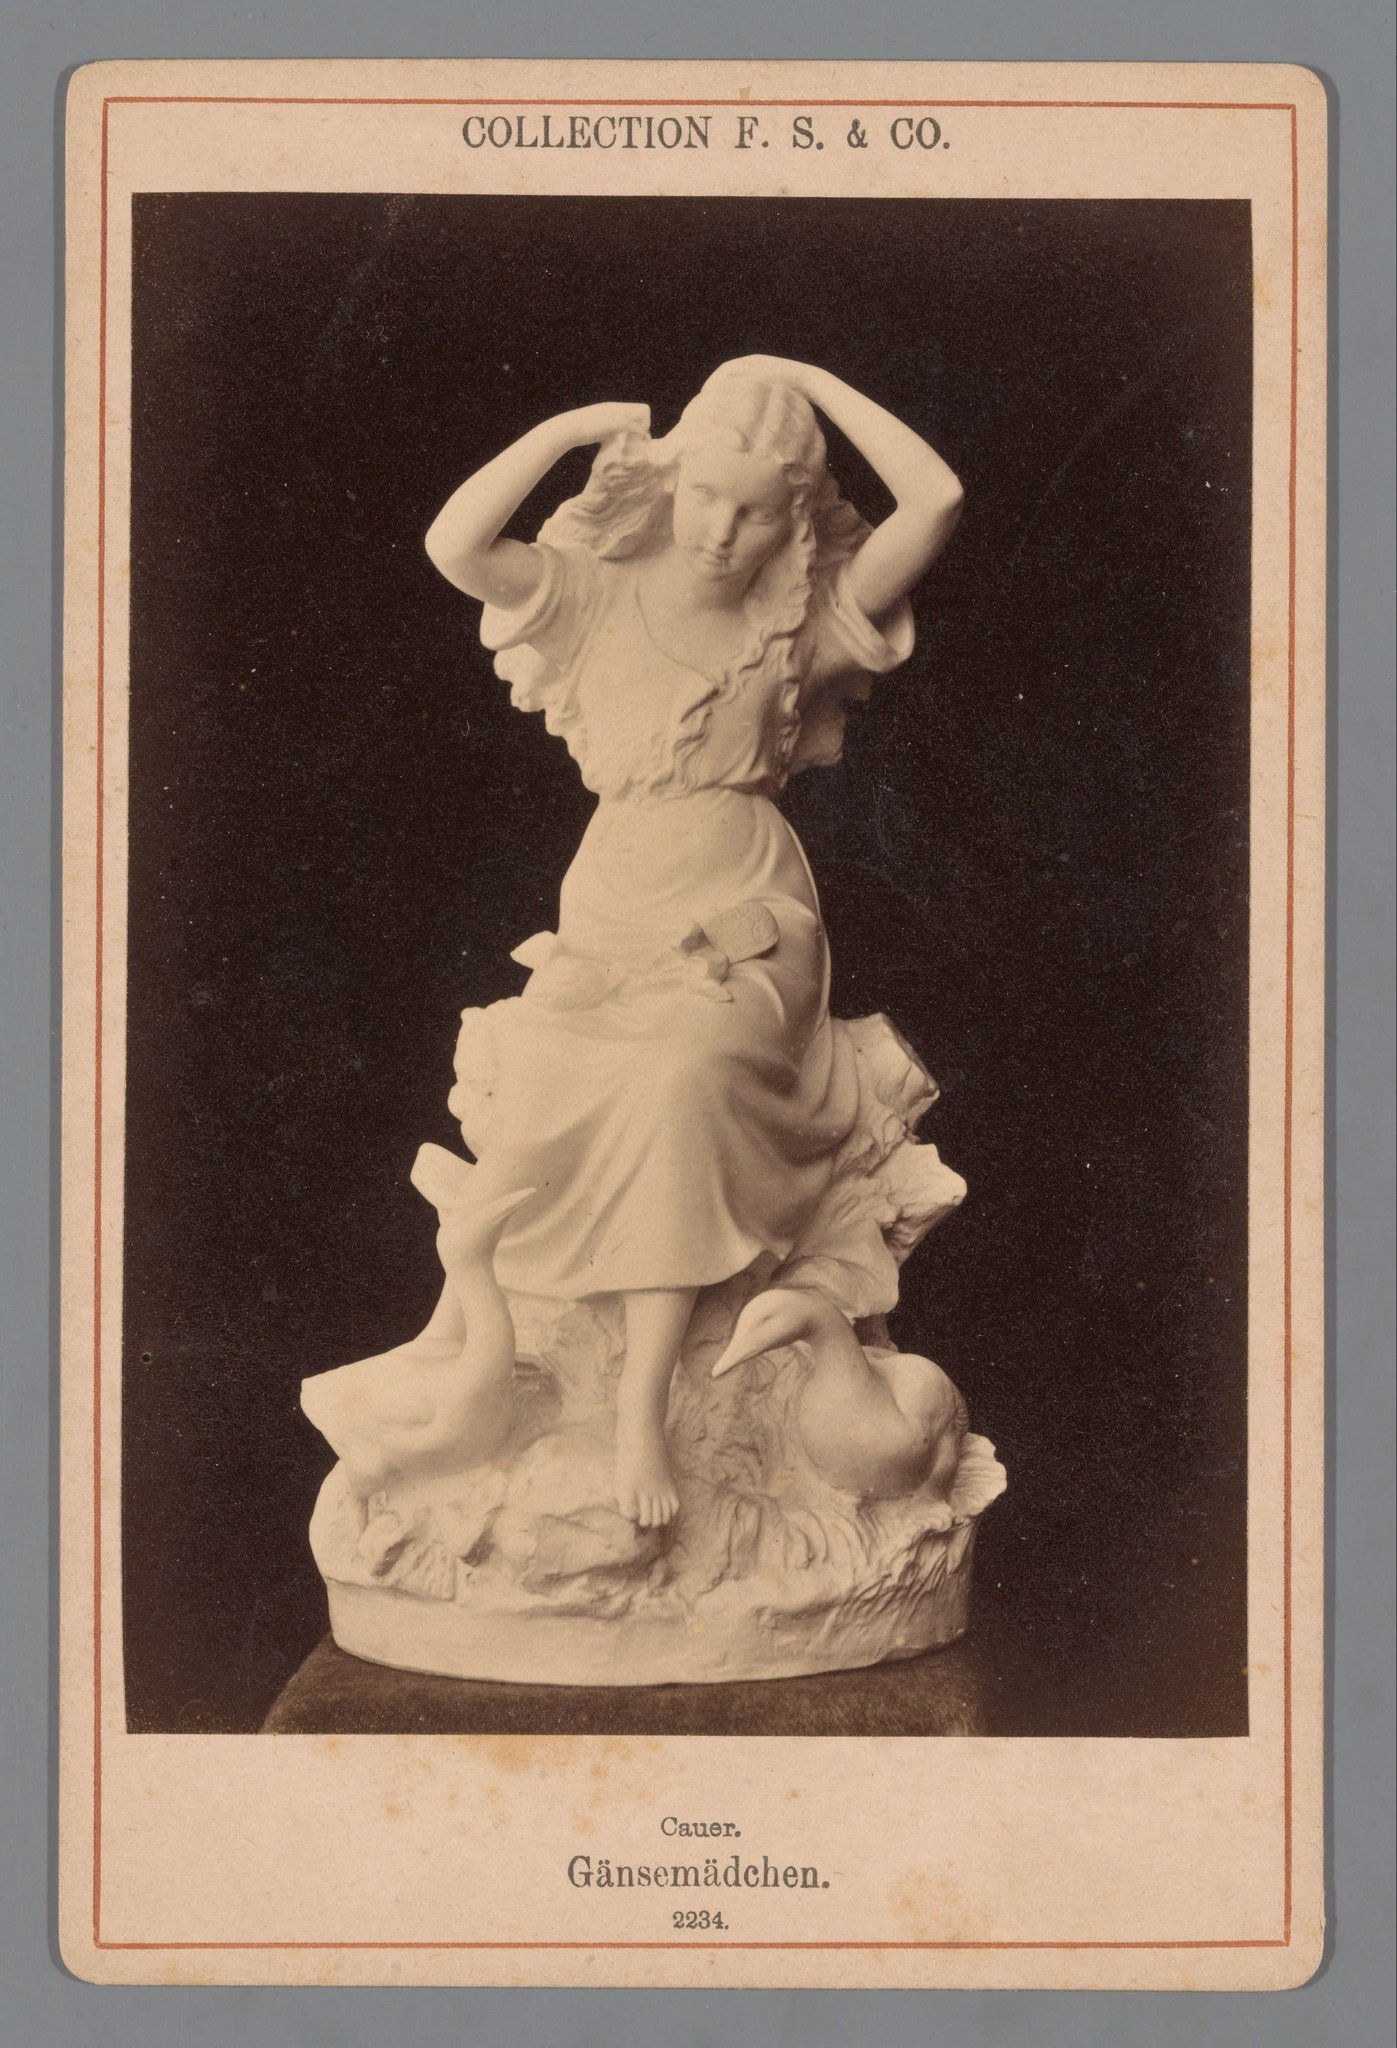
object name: cabinet photograph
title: Sculptuur van een meisje met ganzen door vermoedelijk Carl Cauer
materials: cardboard, photographic support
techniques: albumen print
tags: piece of sculpture, reproduction of a piece of sculpture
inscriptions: number: ‘2234.’, inscription: ‘En souvenir de votre affectionnée voisine Marie v.d. Schrieck.’